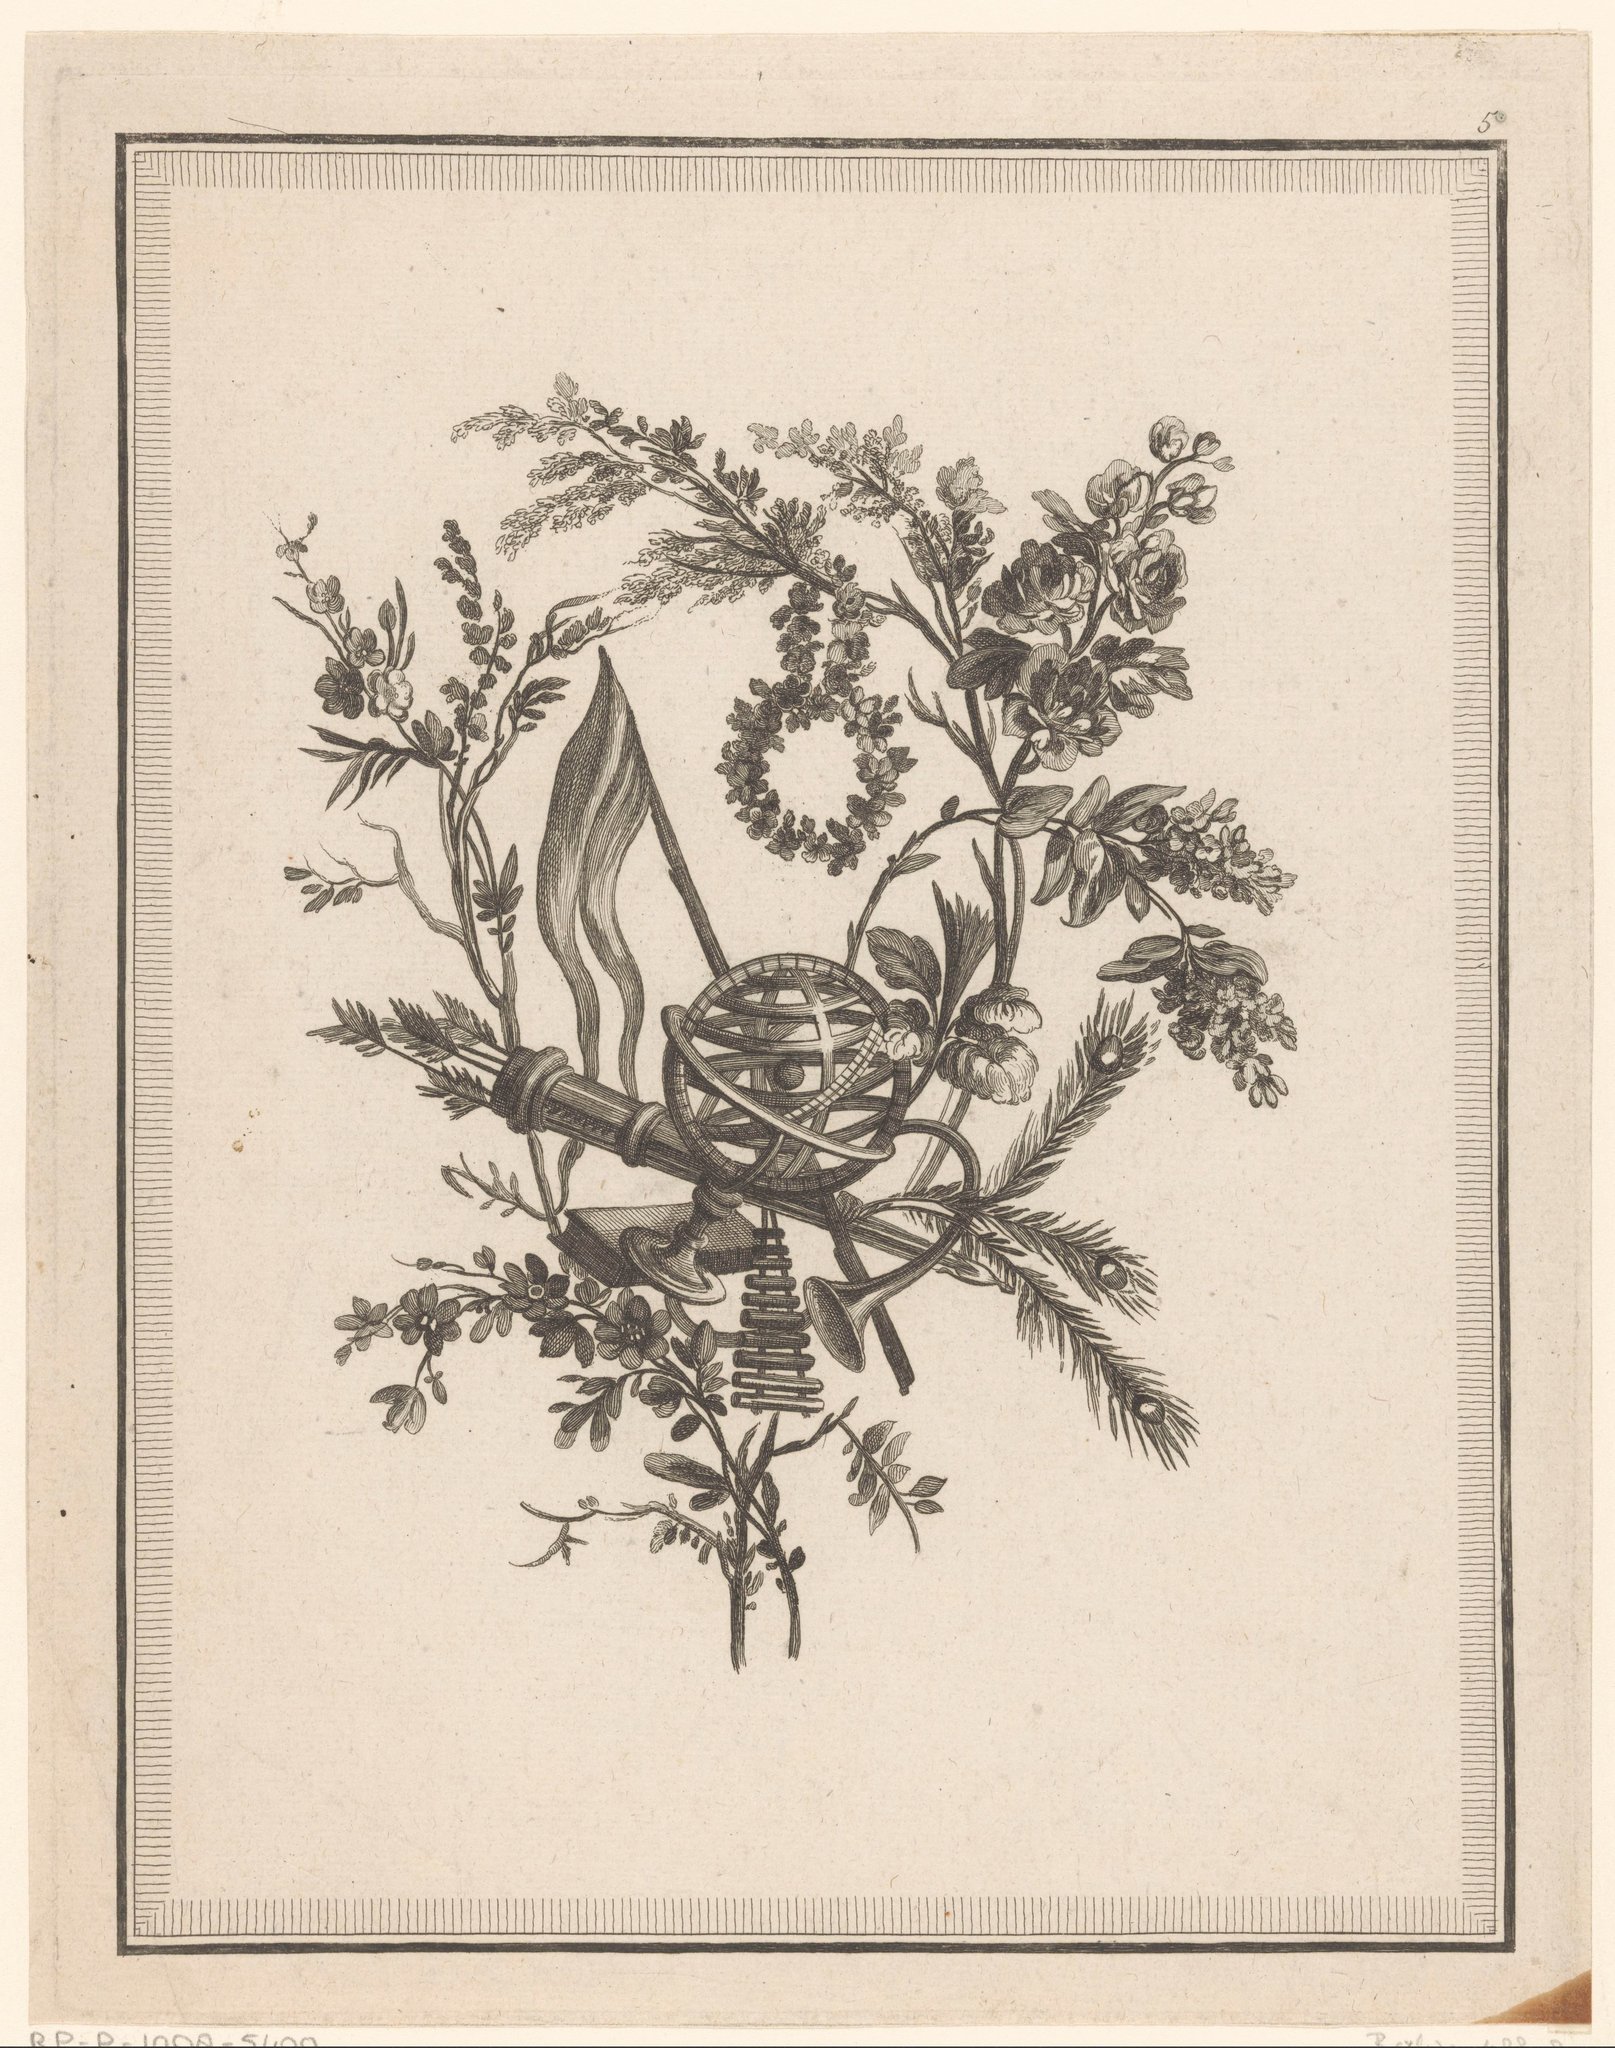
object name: print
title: Trofee met pijlenkoker en armillarium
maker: etienne claude voysard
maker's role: print maker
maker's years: 1746-1812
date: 1778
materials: paper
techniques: etching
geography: paris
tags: quiver, trophy, i.e.: decorative arrangement of symbolic or typical objects ~ ornament, armillary sphere, skeleton celestial globe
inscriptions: collector's mark: Lugt 2228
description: Een trofee met bloemen, een vlag, een pijlenkoker, een armillarium en een hoorn.